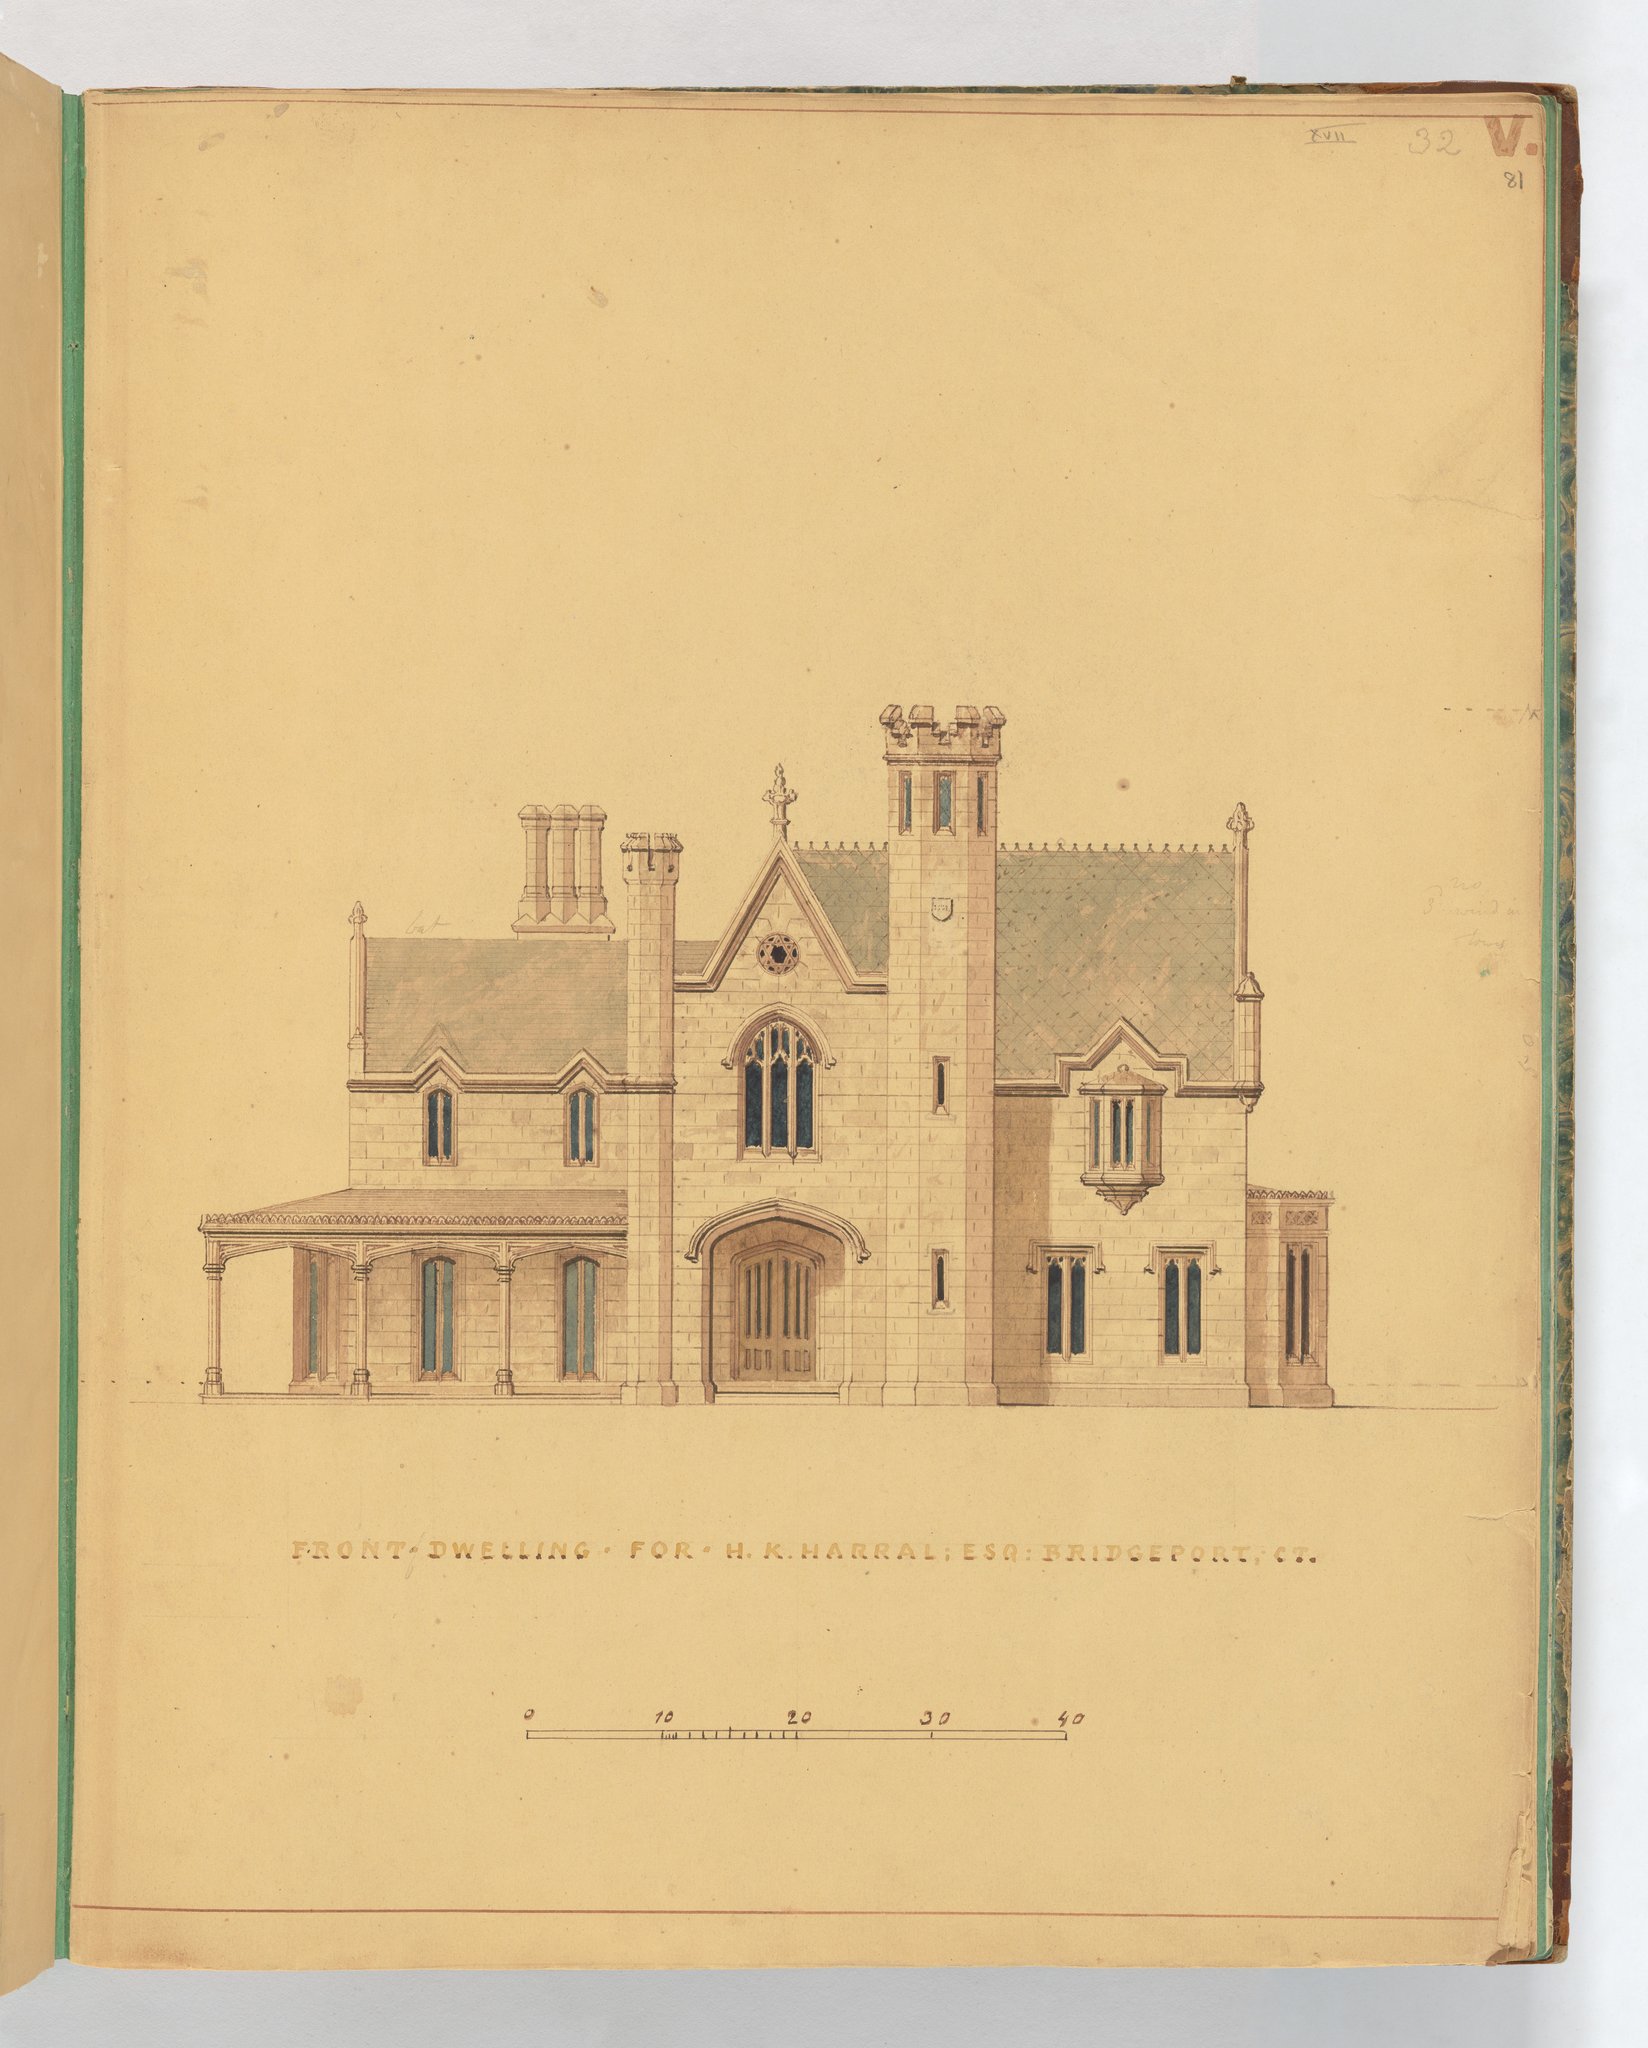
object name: ornament architecture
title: A. J. Davis, Scrapbook XVII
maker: alexander jackson davis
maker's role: artist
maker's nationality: american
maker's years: 1803-1892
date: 1835-1892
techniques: bookbinding, drawing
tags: architecture,houses